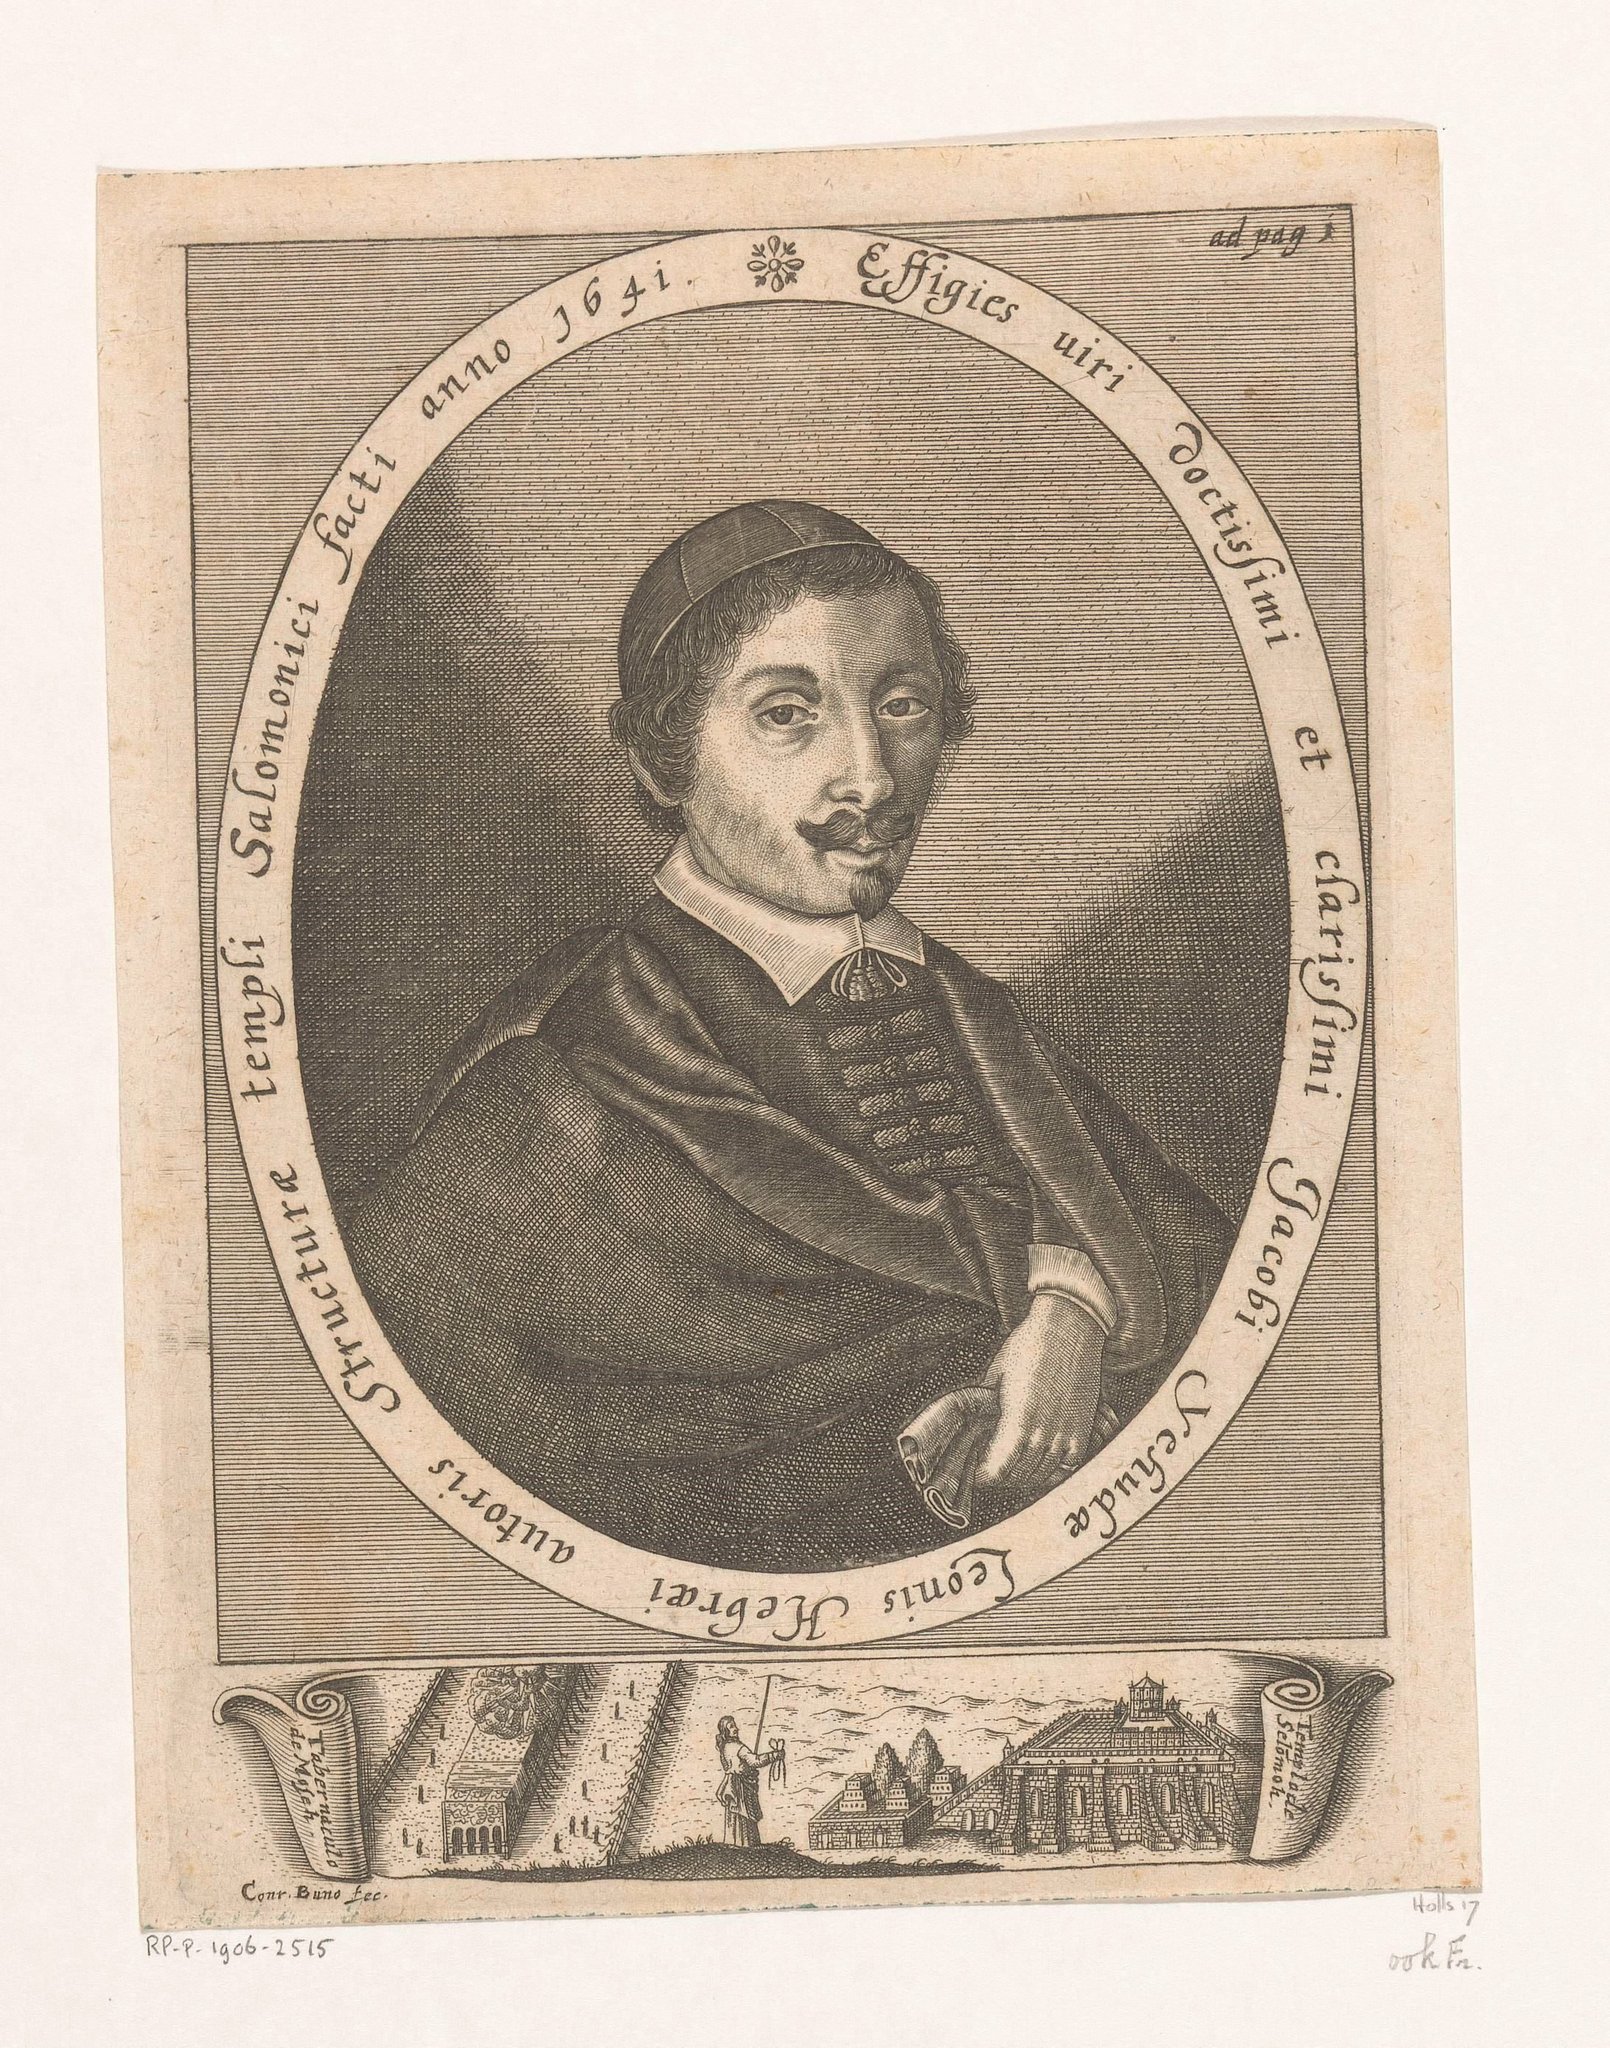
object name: print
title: Portret van Jacob Jehuda Leon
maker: conrad buno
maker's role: print maker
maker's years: 1616-1671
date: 1641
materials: paper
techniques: engraving, etching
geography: braunschweig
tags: gloves, mittens, etc., historical persons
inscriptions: collector's mark: Lugt 2228